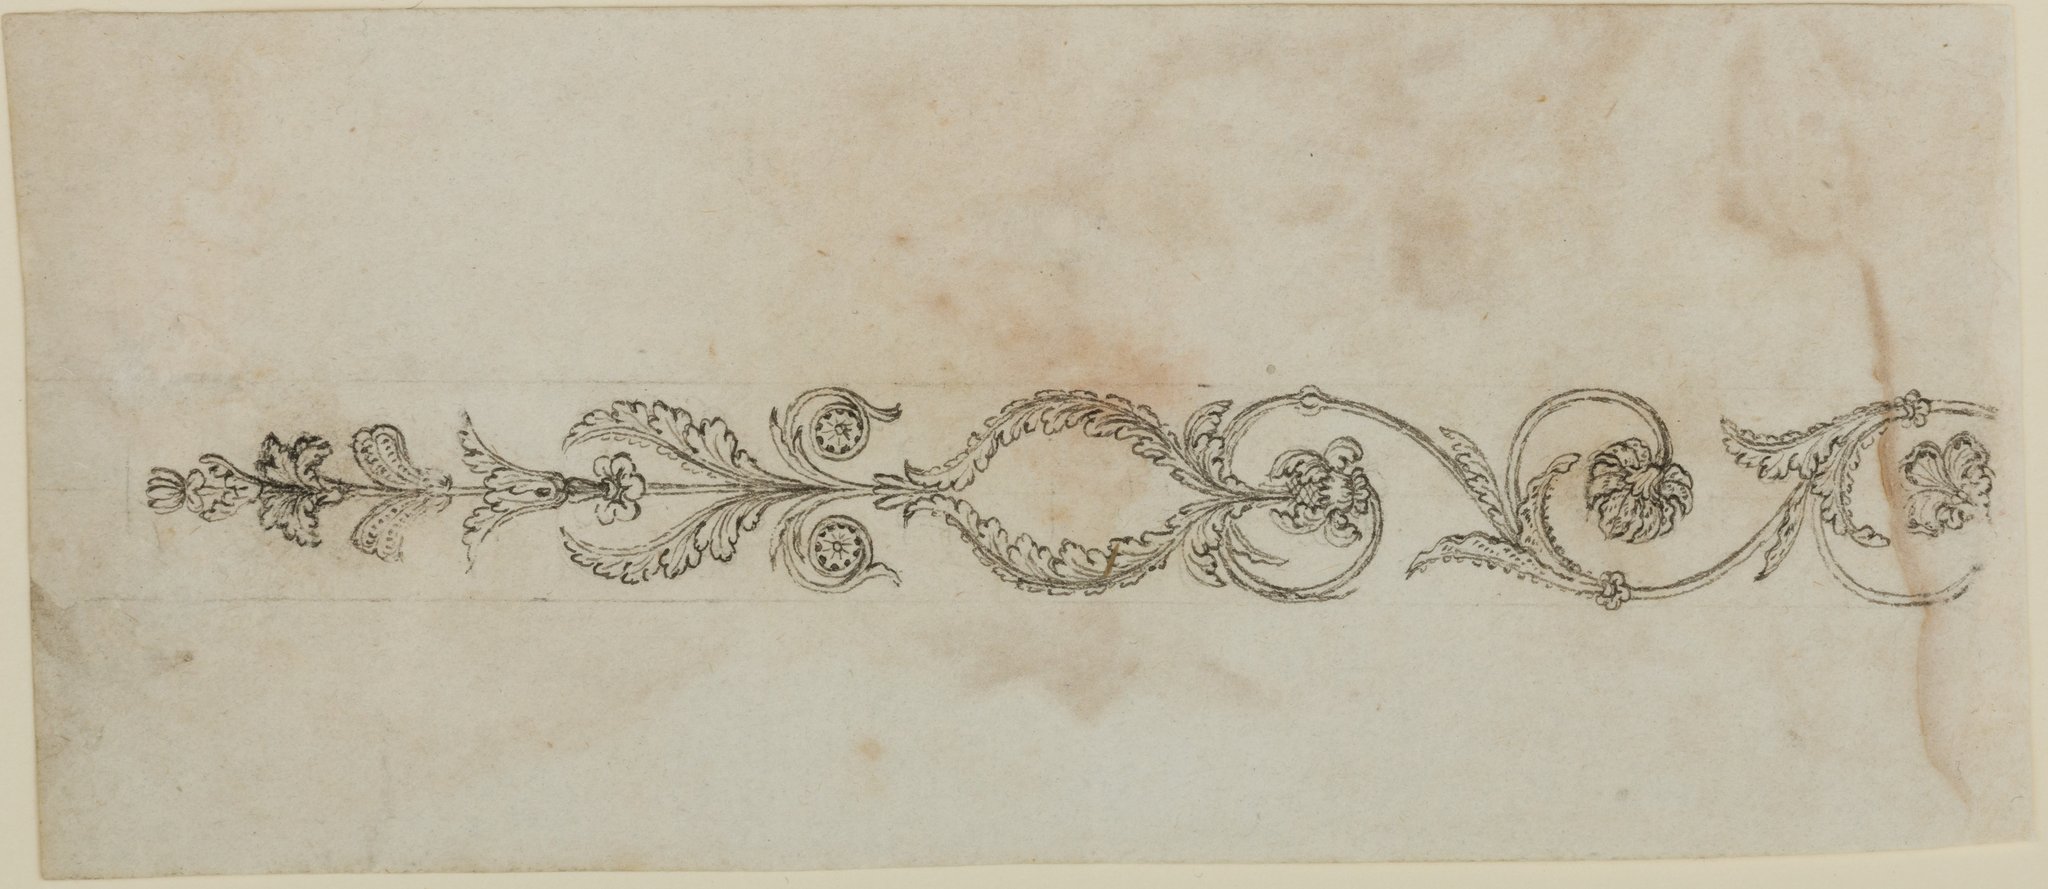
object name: drawing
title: Design for the Decoration of Firearms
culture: french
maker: nicolas noël boutet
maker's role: designer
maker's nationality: french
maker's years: 1761-1833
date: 1797-1805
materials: ink, paper, pencil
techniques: wash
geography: france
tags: ornament